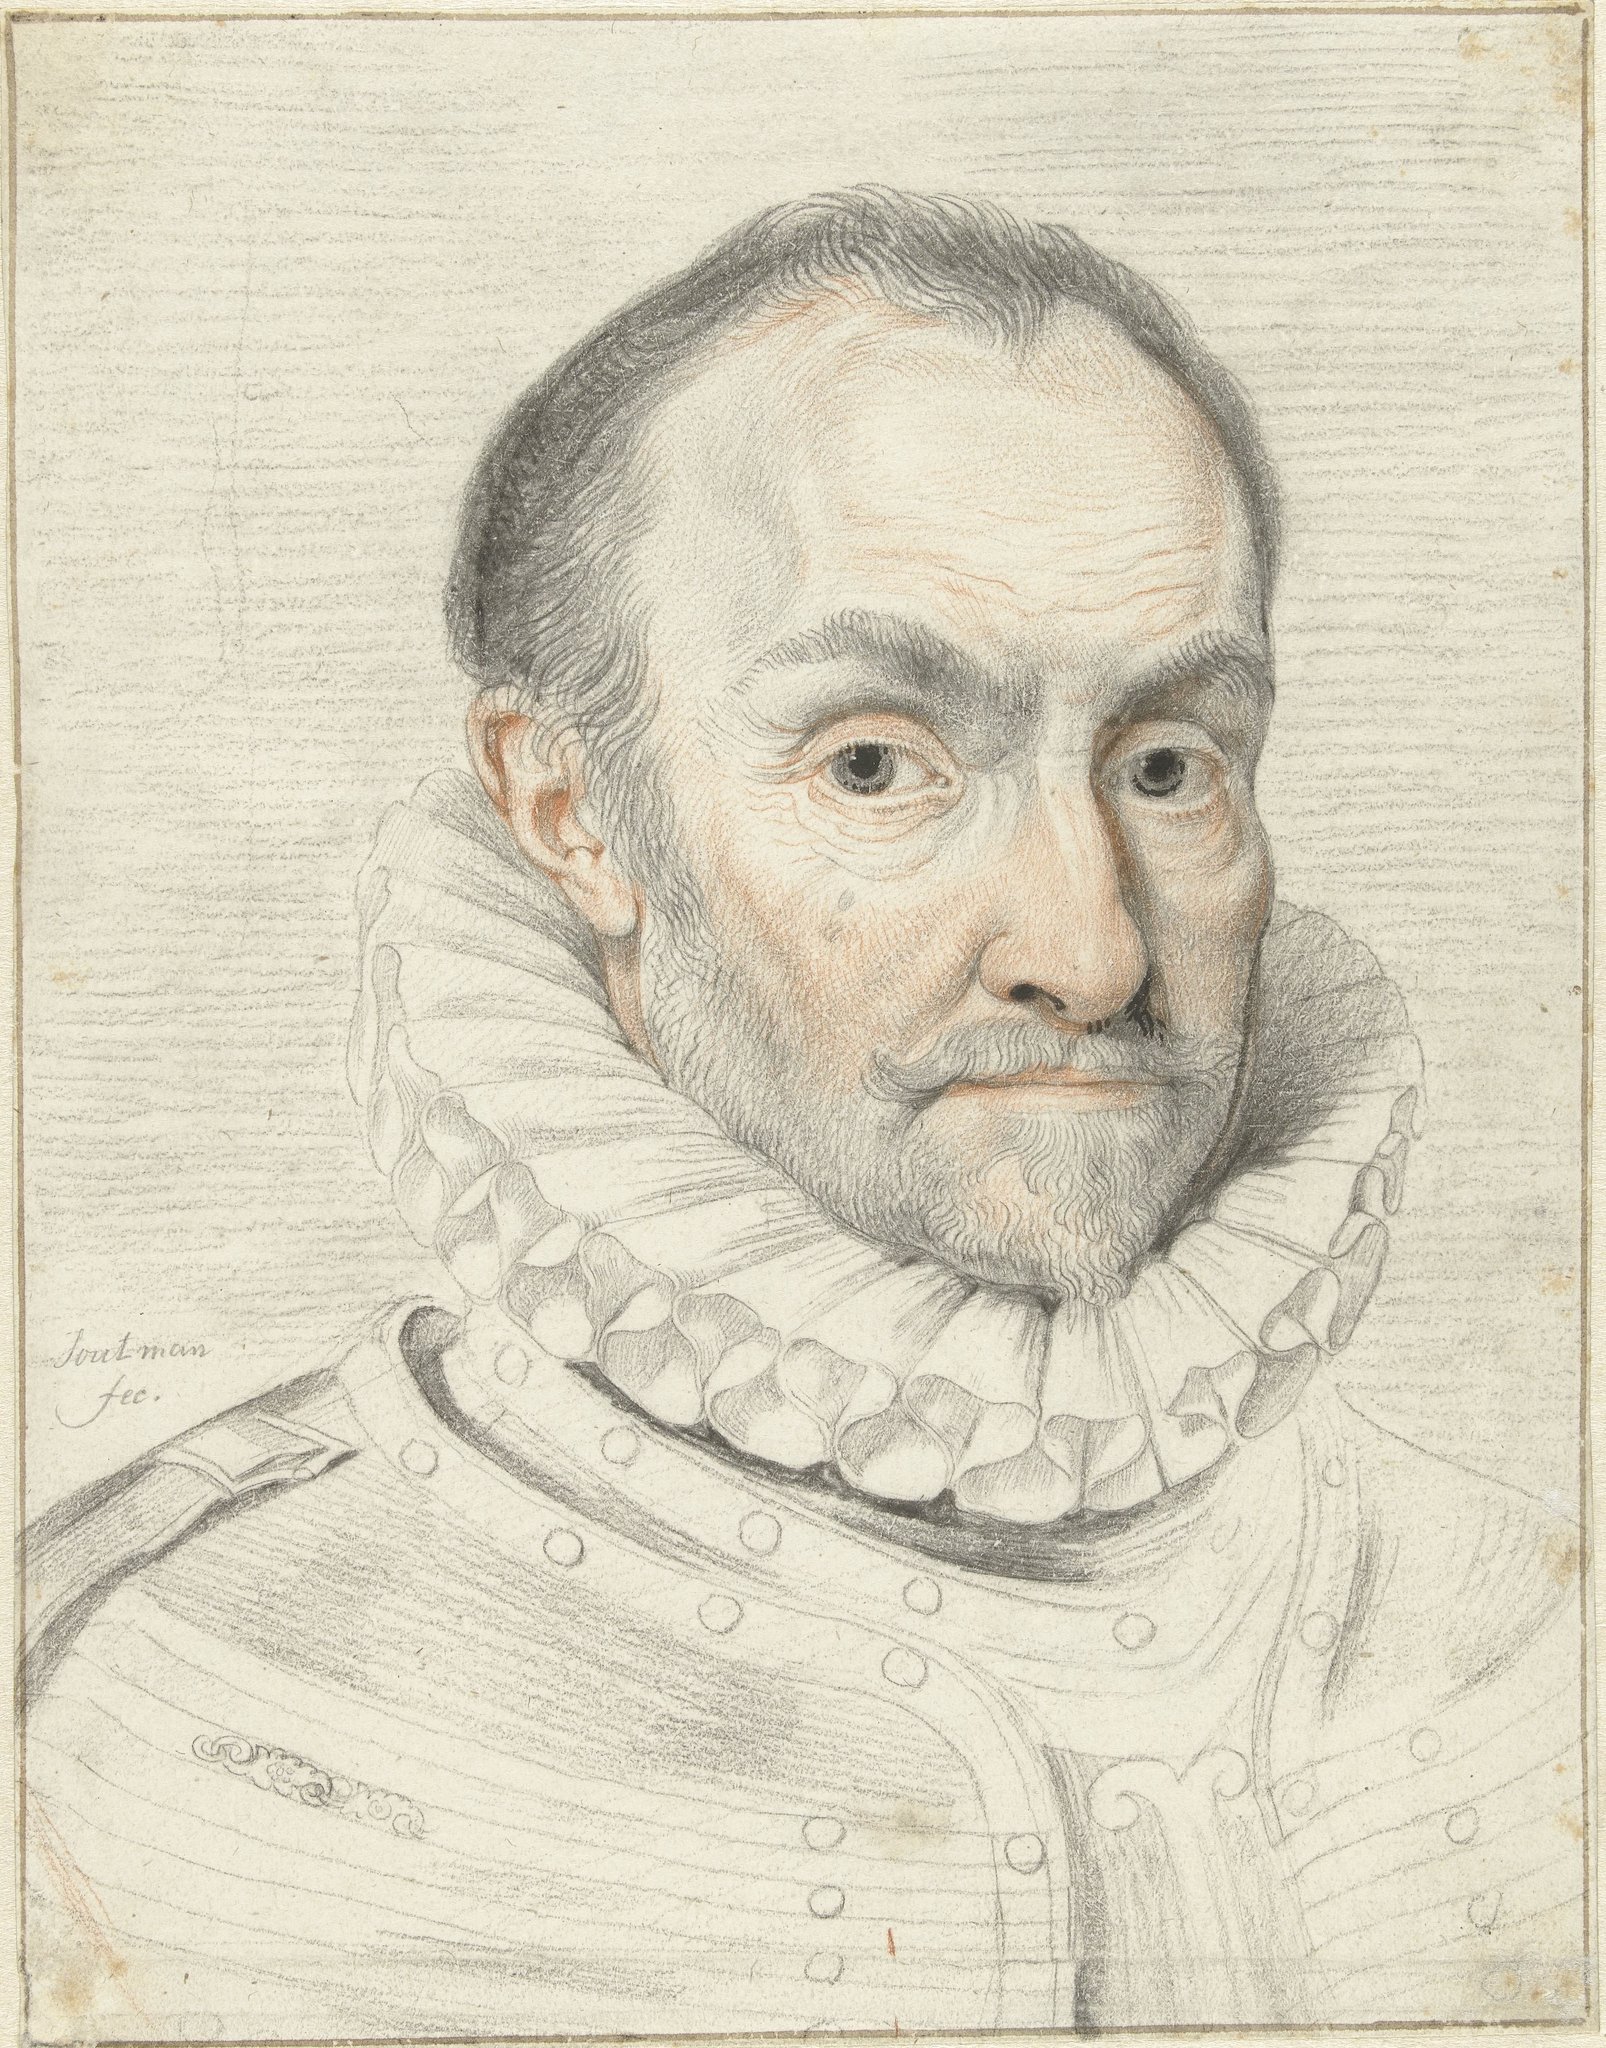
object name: drawing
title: Portret van Prins Willem I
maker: pieter claesz. soutman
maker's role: draughtsman, print maker, publisher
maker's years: 1593-1657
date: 1638-1643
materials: chalk, paper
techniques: brush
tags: delft, william i (prince of orange), historical persons